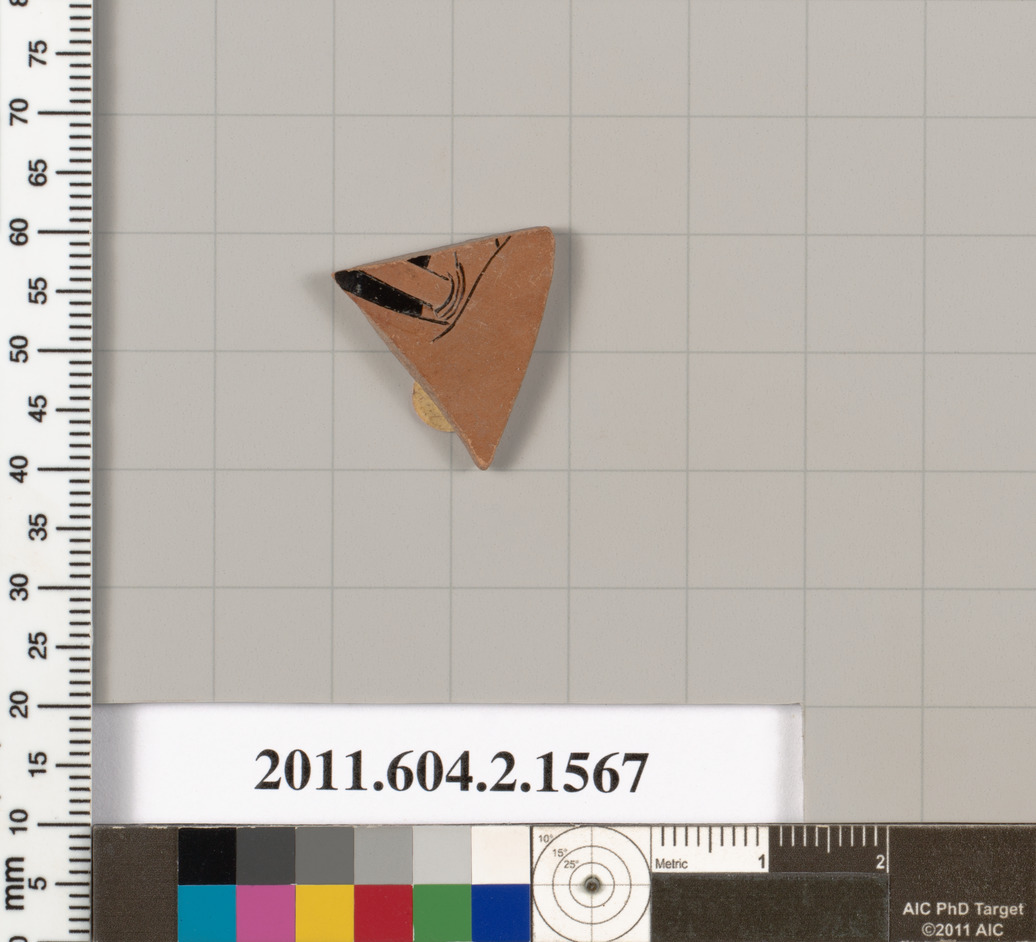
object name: skyphos fragment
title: Terracotta fragment of a skyphos (deep drinking cup)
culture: greek, attic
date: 490-470 BCE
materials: terracotta